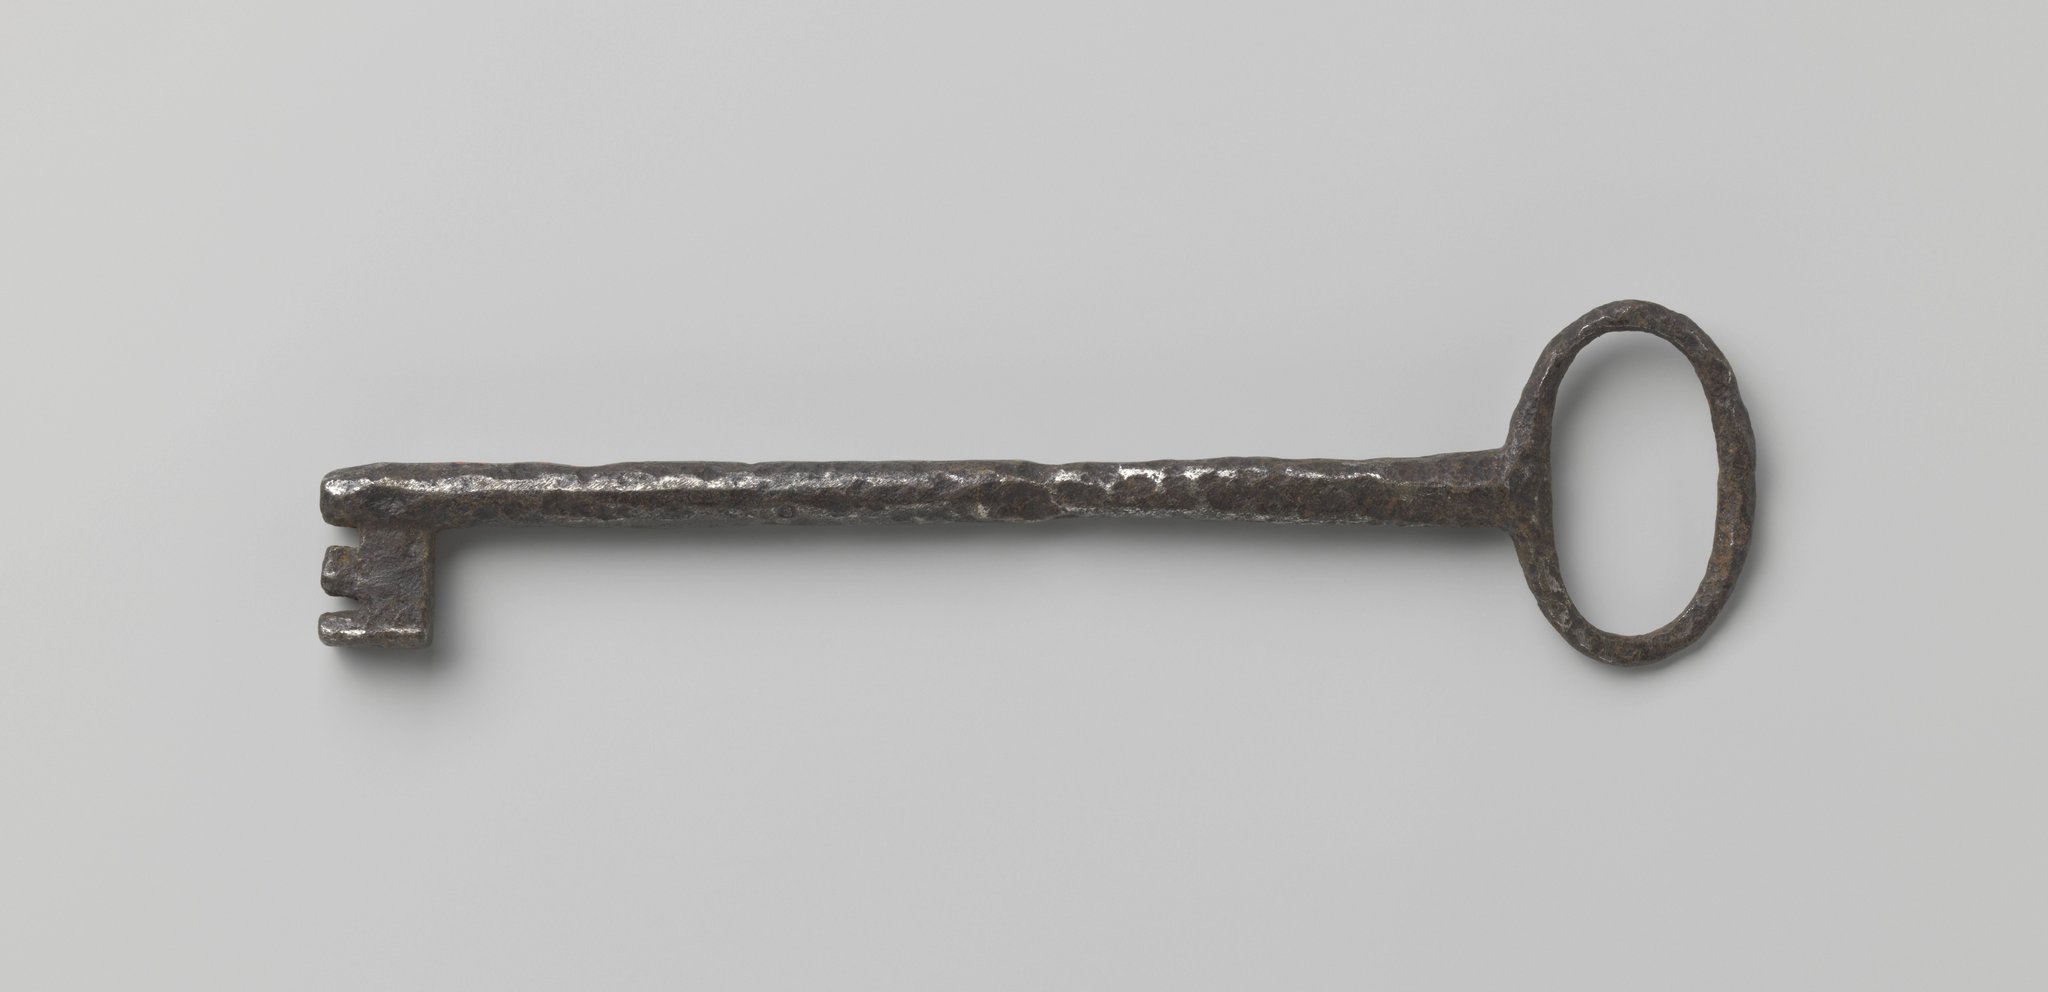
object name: key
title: Sleutel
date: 1600-1699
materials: iron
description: Lange sleutel met kleine baard en ovaal oog.